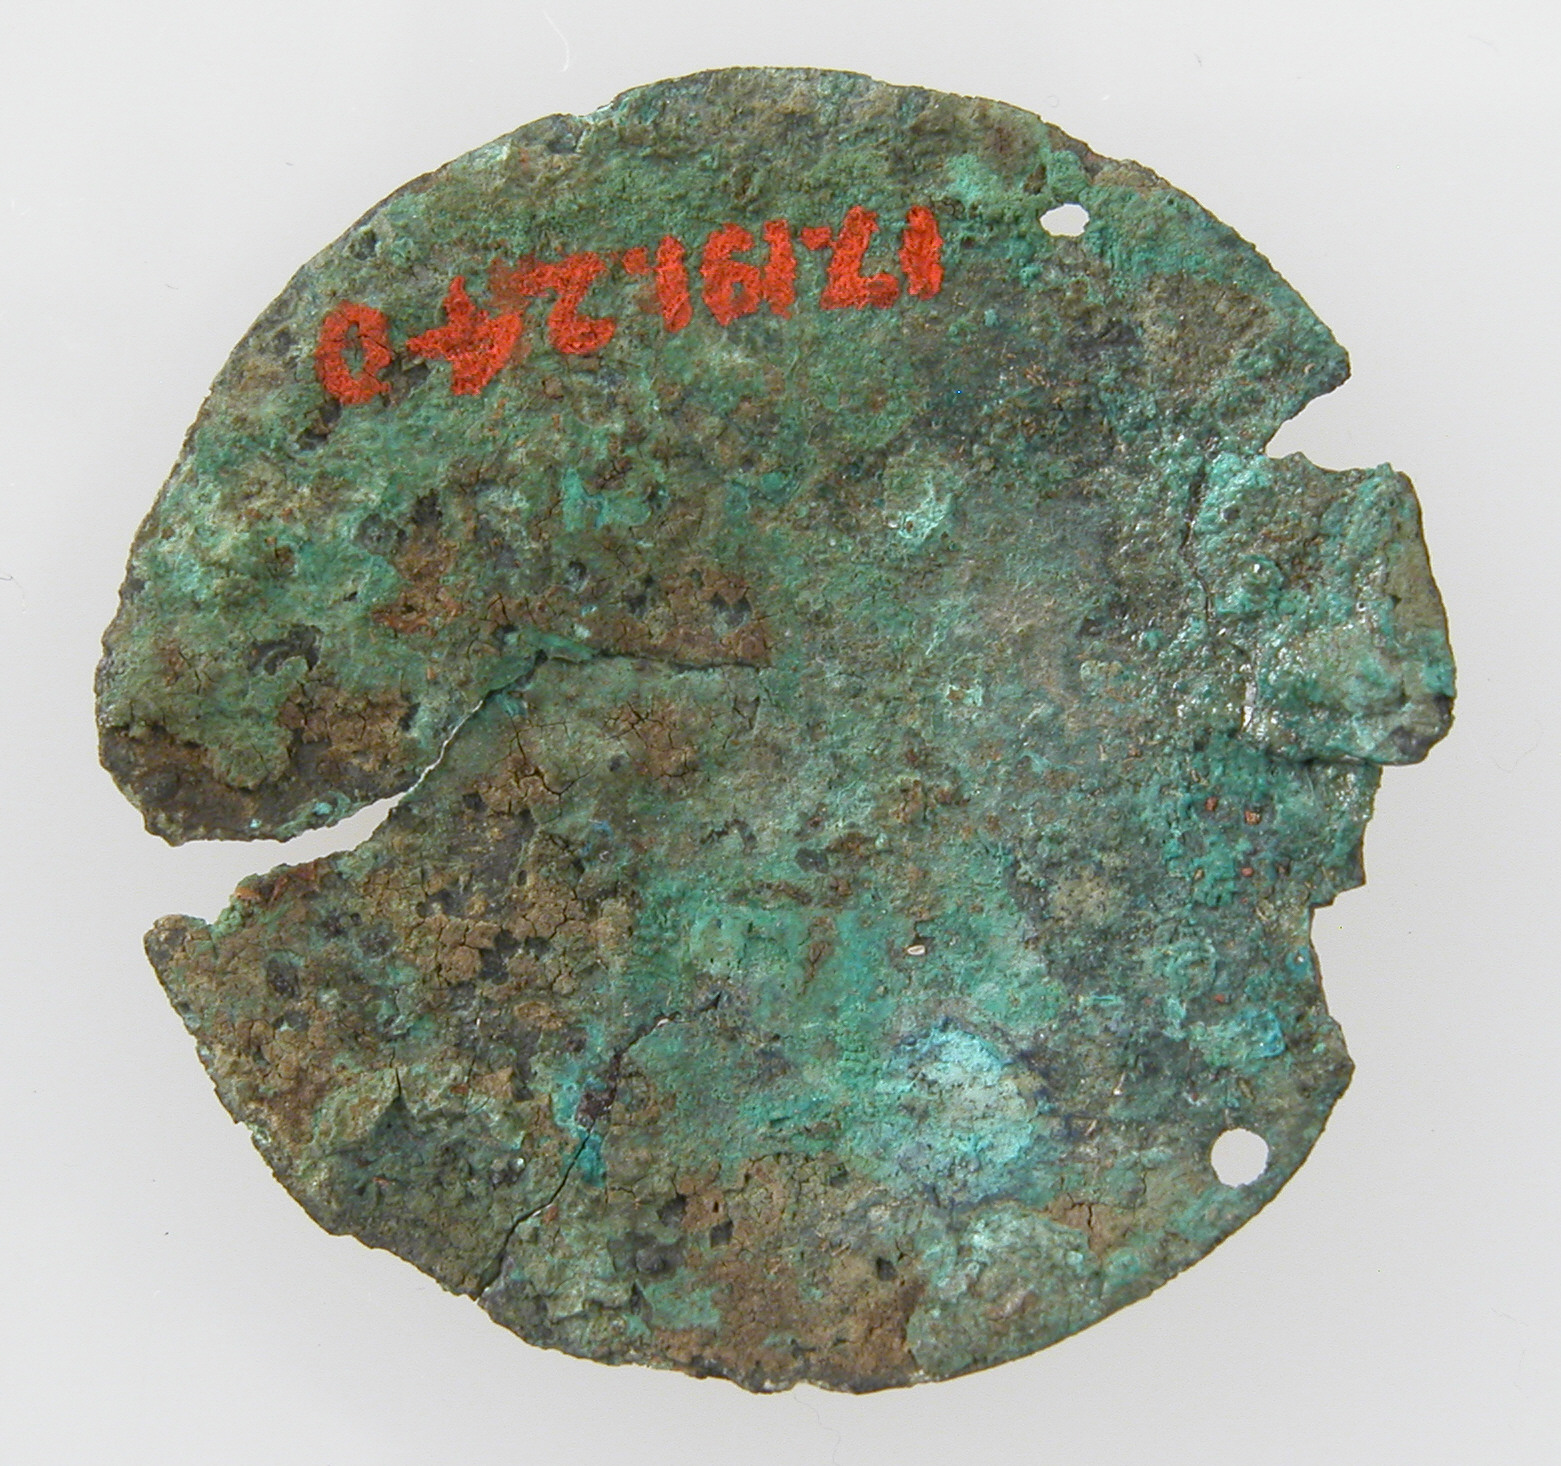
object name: disk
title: Back of Disk Brooch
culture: frankish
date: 500-600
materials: copper alloy